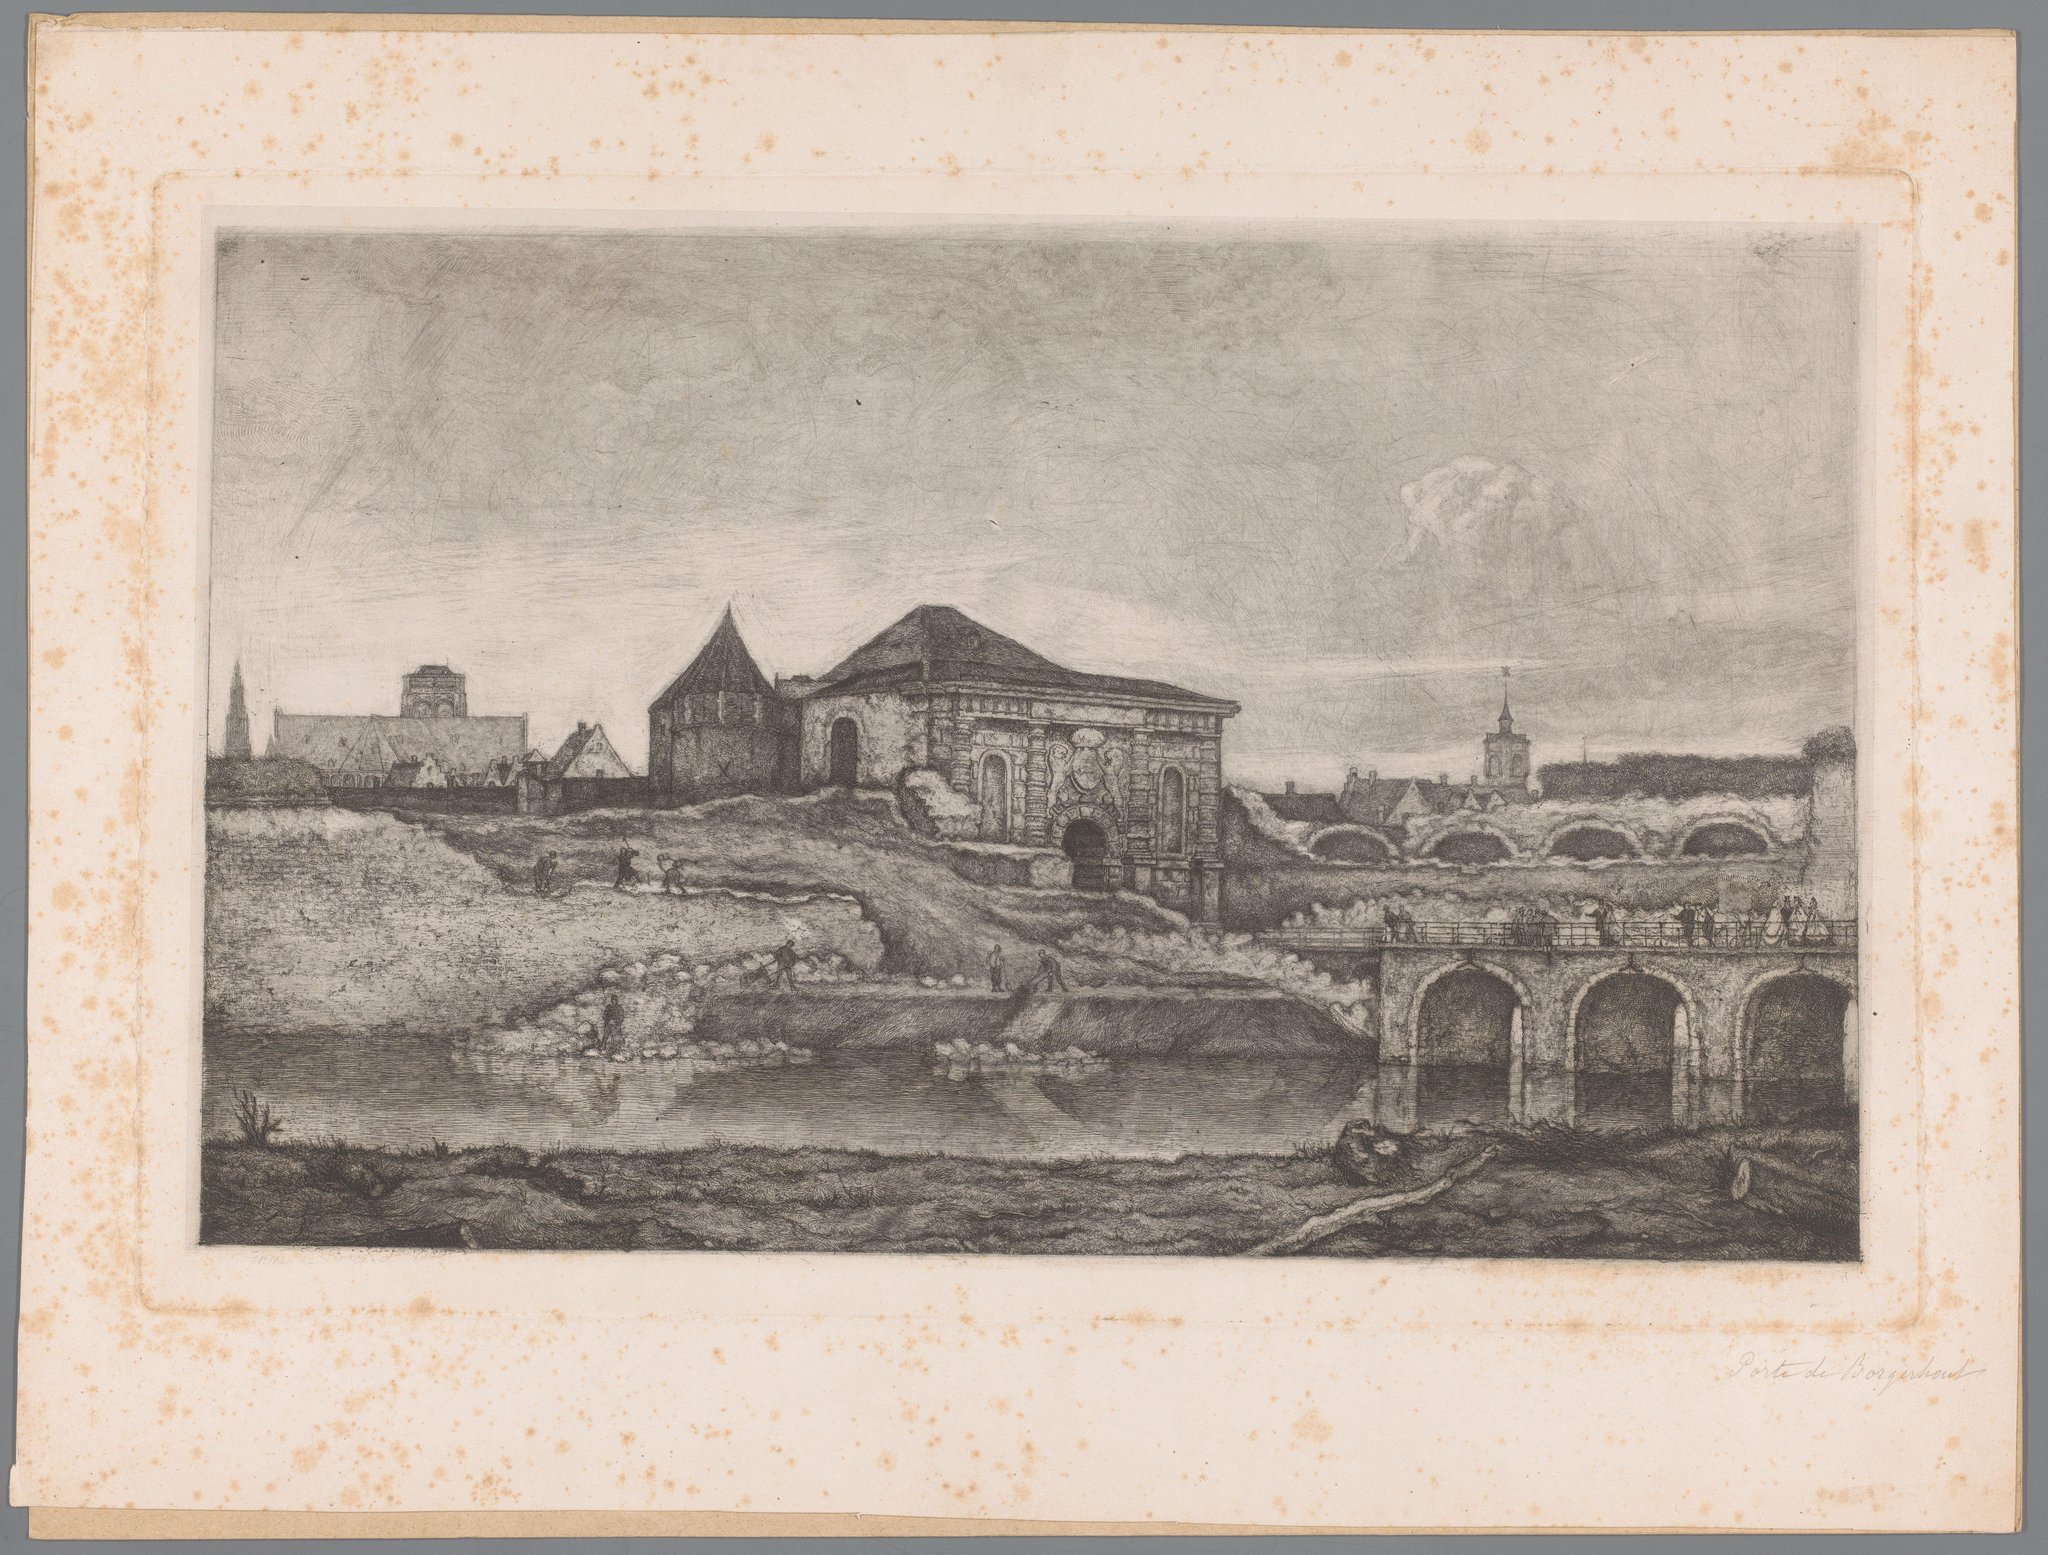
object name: print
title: Gezicht op de Borgerhoutse Poort in Antwerpen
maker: willem linnig (ii)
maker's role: print maker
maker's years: 1842-1890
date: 1865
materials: paper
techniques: etching, intaglio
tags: bridge in city across river, canal, etc., city-gate, antwerp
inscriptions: collector's mark: Lugt 2228